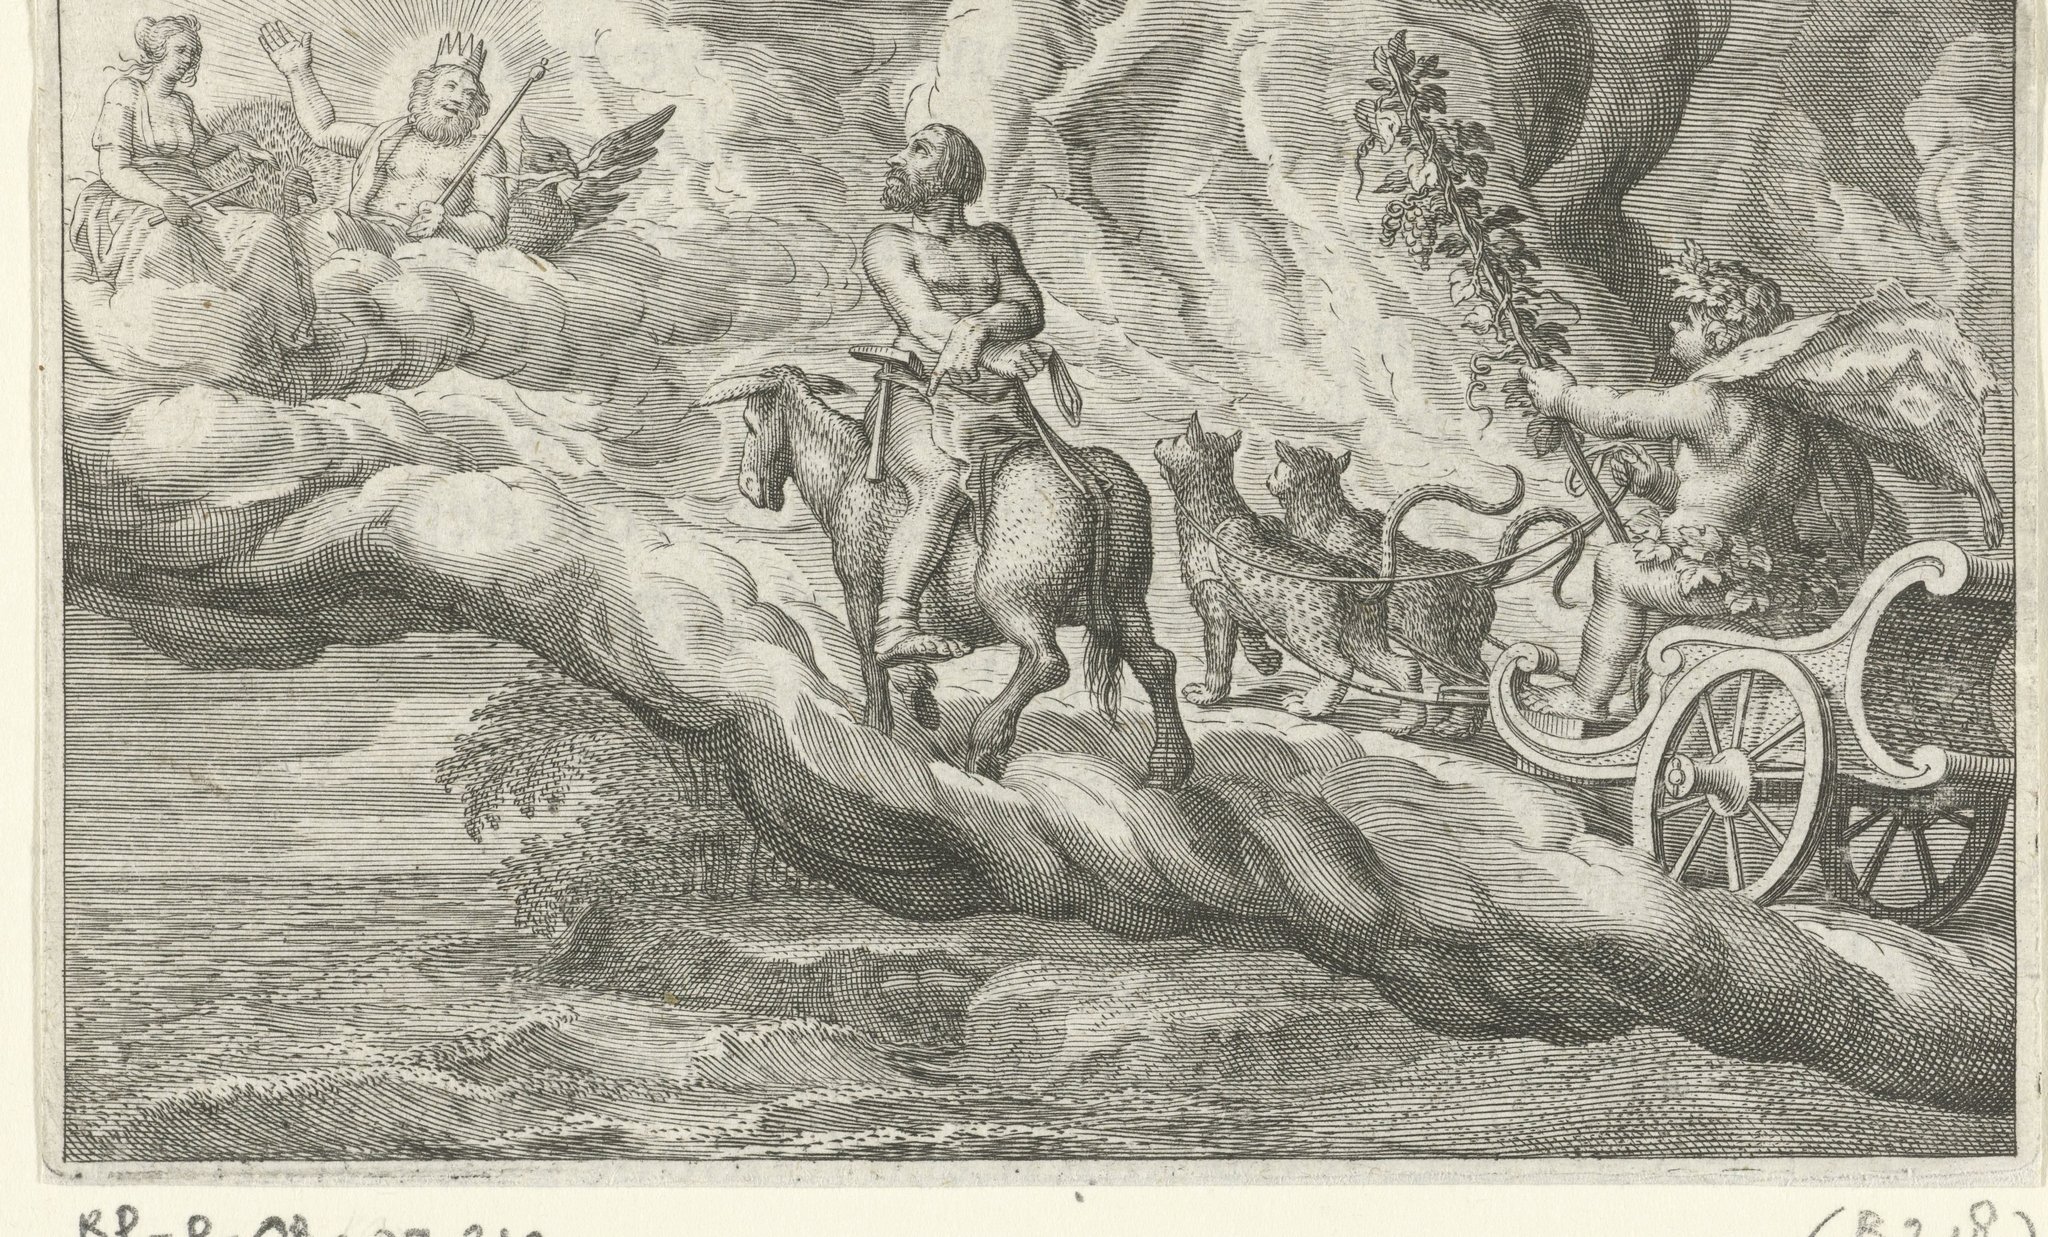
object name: book illustration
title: Terugkeer van Vulcanus met Bacchus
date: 1616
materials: paper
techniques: engraving, letterpress printing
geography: amsterdam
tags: vulcan's return to the olympus with bacchus and his train (+ variant)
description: Bacchus in zijn door luipaarden getrokken wagen, vergezelt Vulcanus die achterstevoren op een ezel gezeten terugkeert naar de Olympos waar Juno en Jupiter hem verwelkomen. Onder de wolken het eiland Lemnos, waar hij terecht kwam toen hij door Jupiter van de Olympos was gegooid. Boekillustratie voor: Lof-sanck van Bacchus, 1616.